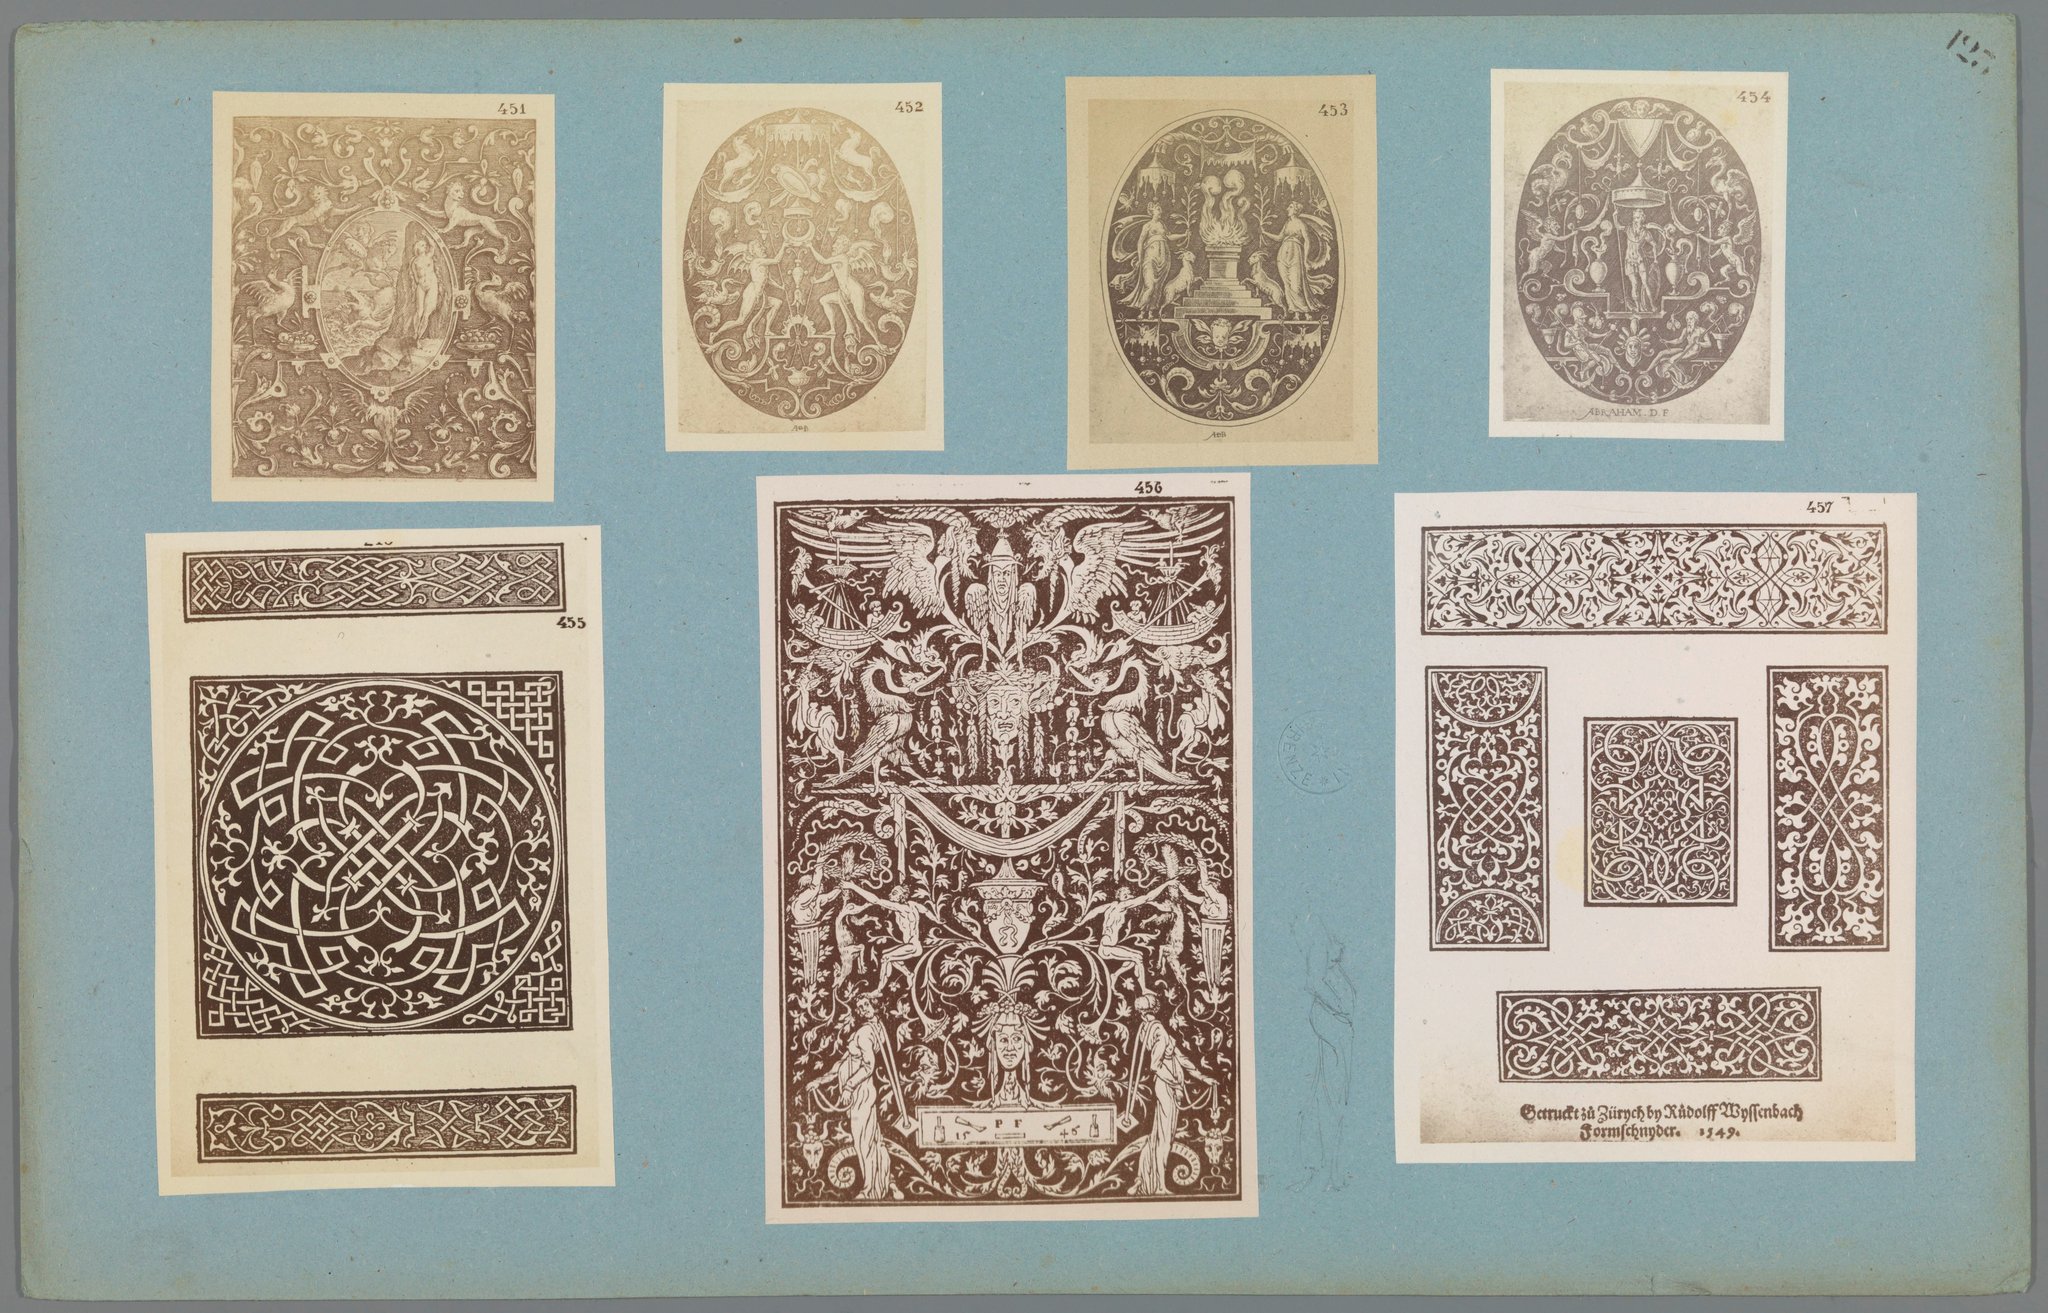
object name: reproduction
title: Zeven fotoreproducties van ornamentprenten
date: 1875-1900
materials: cardboard, photographic support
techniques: albumen print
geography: europe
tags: ornament ~ grotesque, fantasy ornament, abstract interlace, knotwork ~ ornament, andromeda chained to the rock, europe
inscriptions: number: ‘456’, number: ‘453’, collector's mark: Lugt 3937, number: ‘454’, number: ‘455’, number: ‘457’, annotation:, name: ‘C. PINI FIRENZE’, number: ‘123’, number: ‘452’, number: ‘451’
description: Linksboven (455) een prent van Andromeda en Perseus in een medaillon met daaromheen dieren, linksonder (455) een prent van knooppatronen in een vierkant, linksmidden (452) een prent van paarden en gevleugelde figuren in een medaillon, midden (456) een prent van groteske ornamenten, rechtsmidden (453) een prent van twee vrouwen en geiten bij een offertafel in een medaillon, rechtsboven (454) een prent van een bebaarde figuur en gevleugelde wezens in een medaillon, rechtsonder (457) een prent van knooppatronen in vijf rechthoeken.